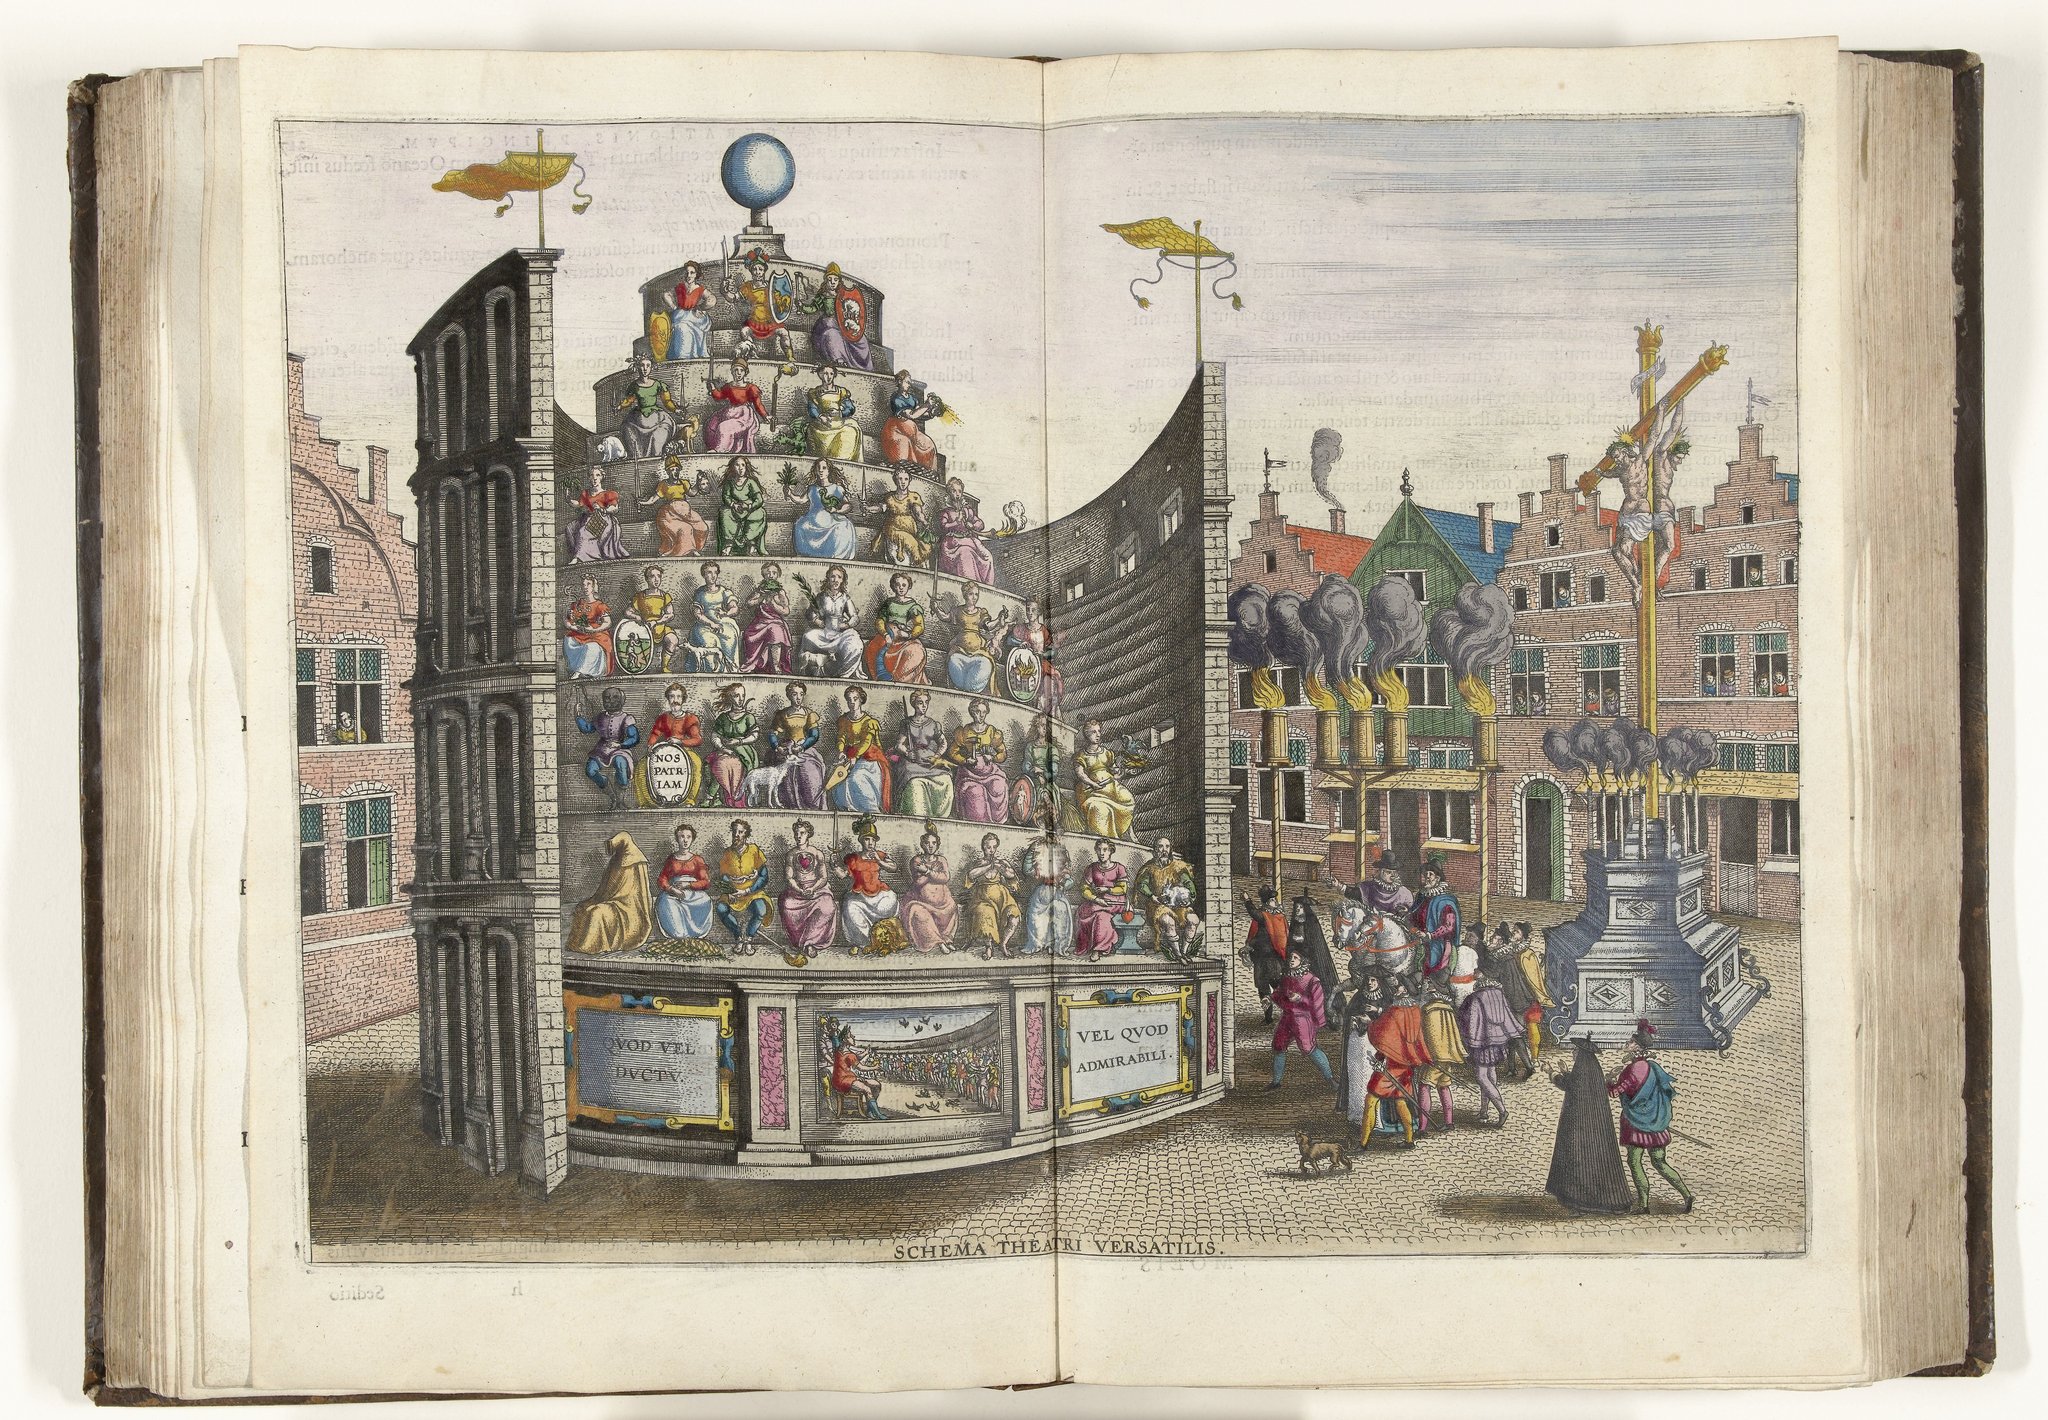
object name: print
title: Theater van oorlog en vrede, 1599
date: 1599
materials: paper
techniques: etching, hand coloring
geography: antwerp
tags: infante van spanje isabella clara eugenia, brussels, albrecht aartshertog van oostenrijk, 'tableau vivant', triumphal entry and public reception, pageant, 'entrée solennelle', 'joyeuse entrée', symbols, allegories of war; 'guerra' (ripa), antwerp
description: Theater van oorlog en vrede, december 1599. Trapsgewijs opgebouwde theater met personificaties van de Oorlog en allerlei hiermee verbonden begrippen. Gesitueerd aan een plein tegenover een dubbel kruisbeeld, Tijdens de intocht te Antwerpen opgesteld op de Meirbrug. Onderdeel van: Historica narratio profectionis et inaugurationis serenissimorum Belgii principum Alberti et Isabellae Austriae archiducum, de beschrijving van de intochten van het paar te Brussel, Antwerpen, Gent en Valenciennes, 1599.